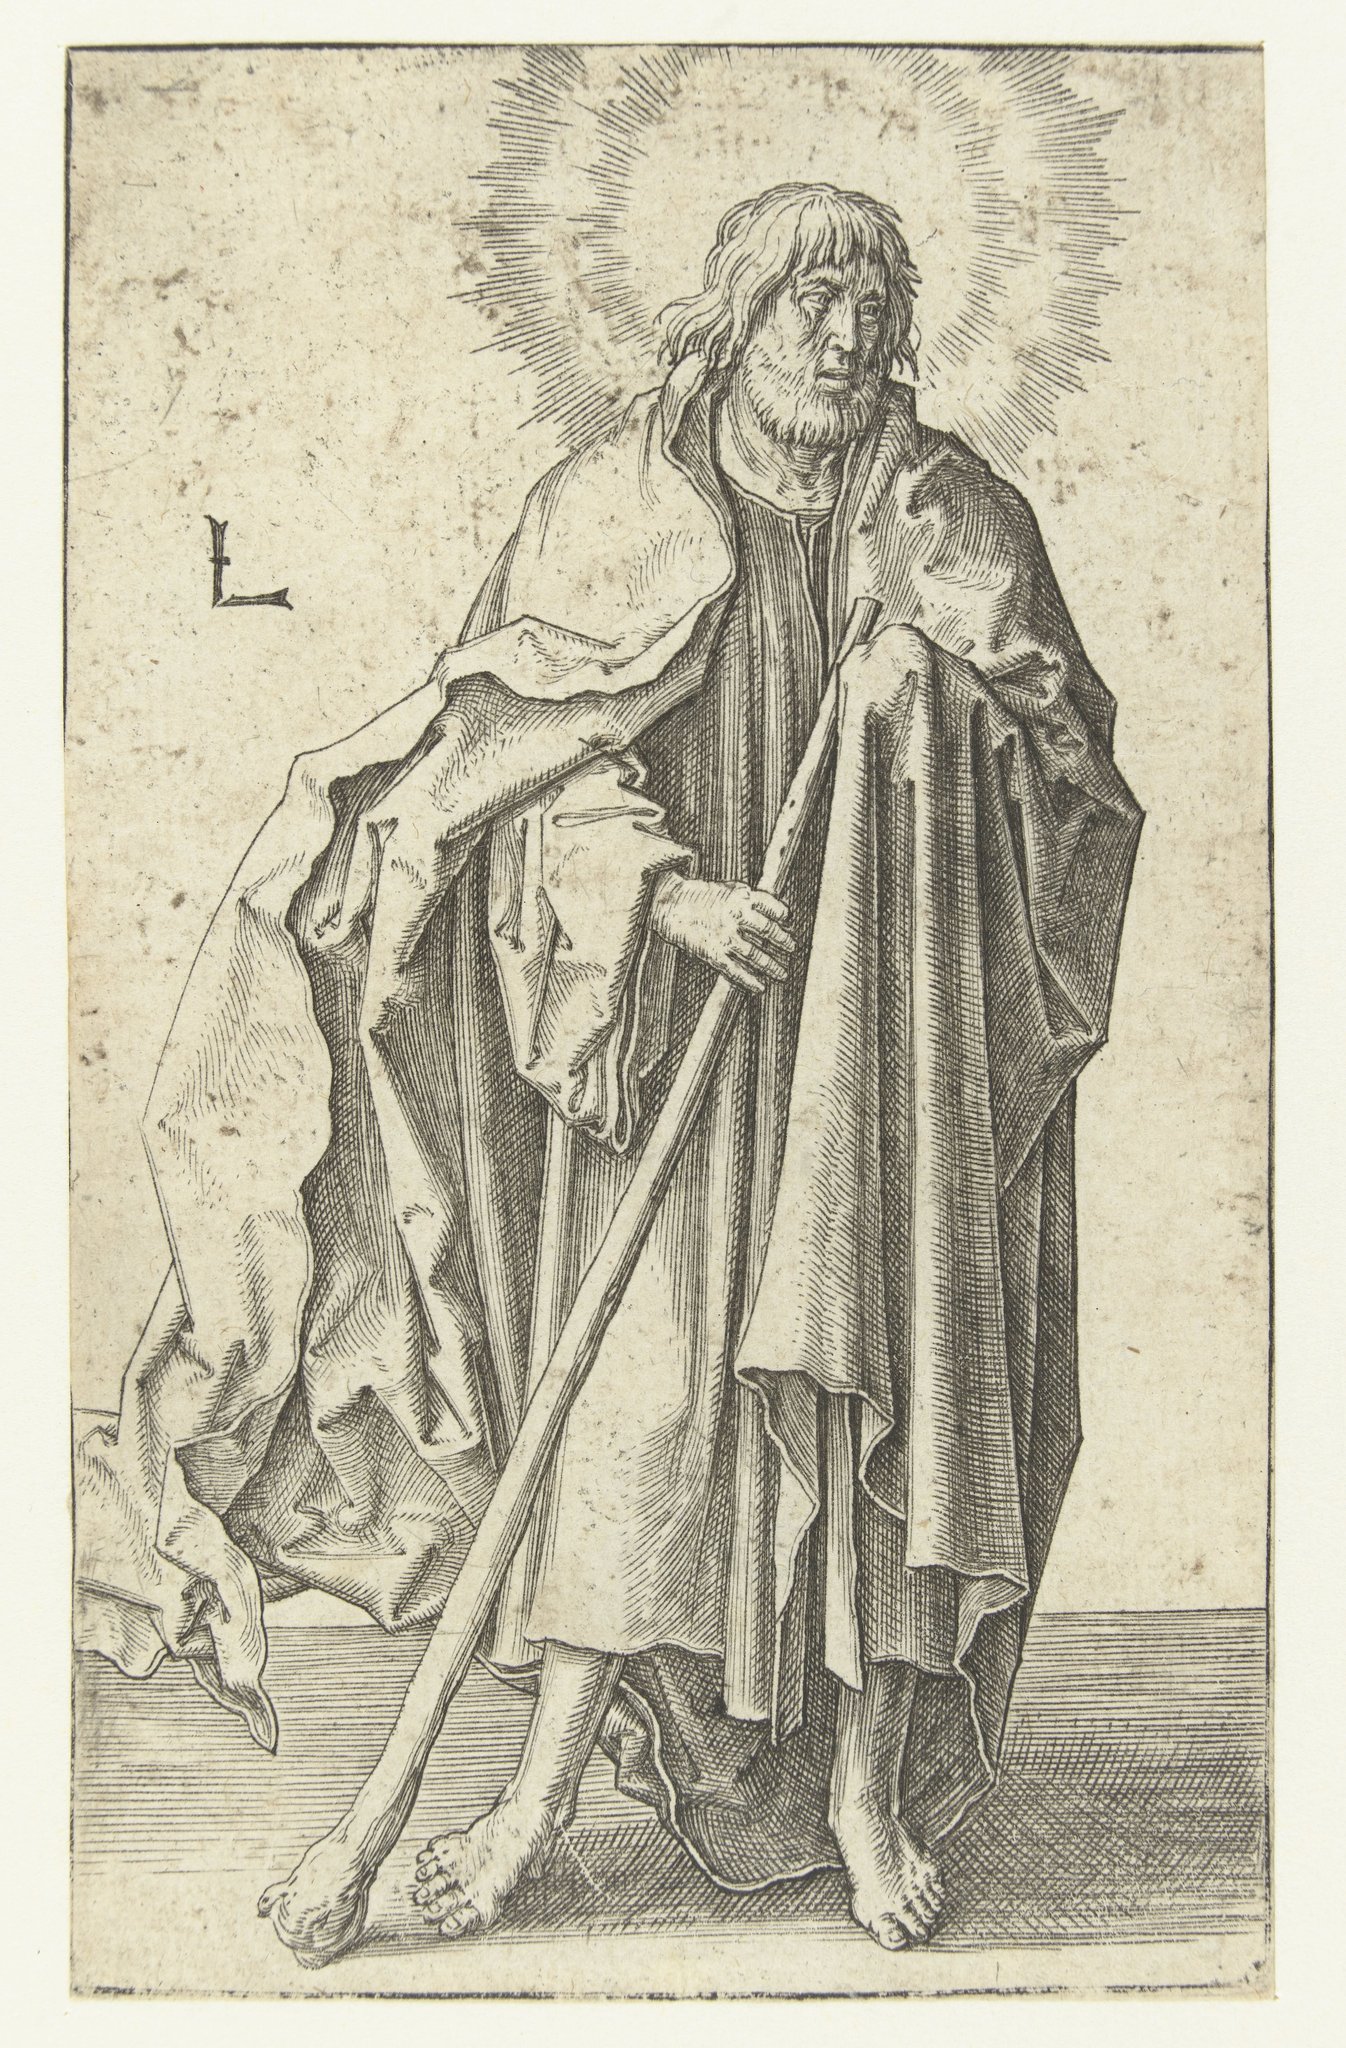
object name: print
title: De apostel Judas Thaddeüs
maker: lucas van leyden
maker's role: draughtsman, painter, print maker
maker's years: 1494-1533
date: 1508-1512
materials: paper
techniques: engraving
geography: low countries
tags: the apostle james the less, first bishop of jerusalem; possible attributes: book, fuller's club, scroll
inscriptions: collector's mark: Lugt 11